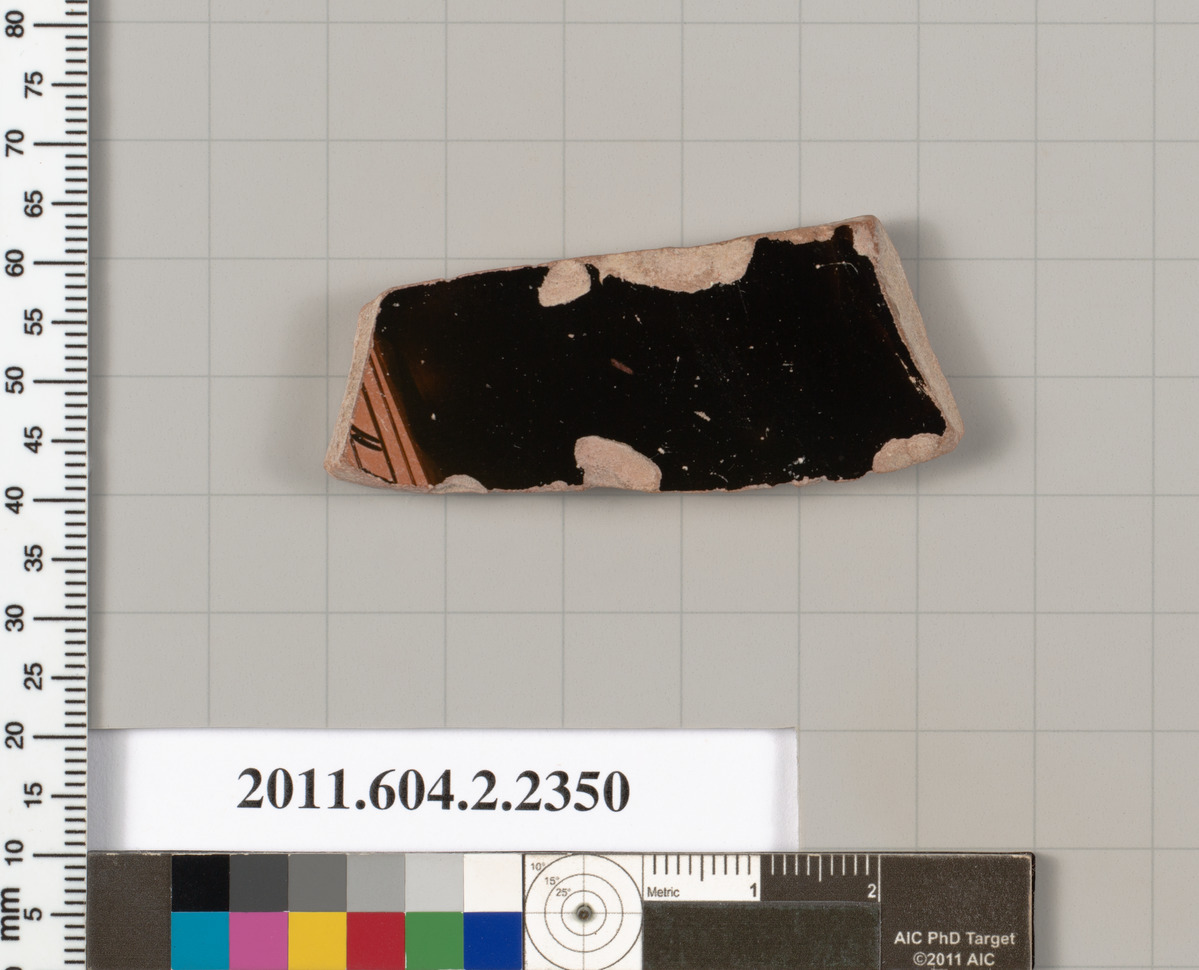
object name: bell krater fragment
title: Terracotta fragment of a bell-krater (bowl for mixing wine and water)?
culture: greek, attic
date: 500-476 BCE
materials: terracotta